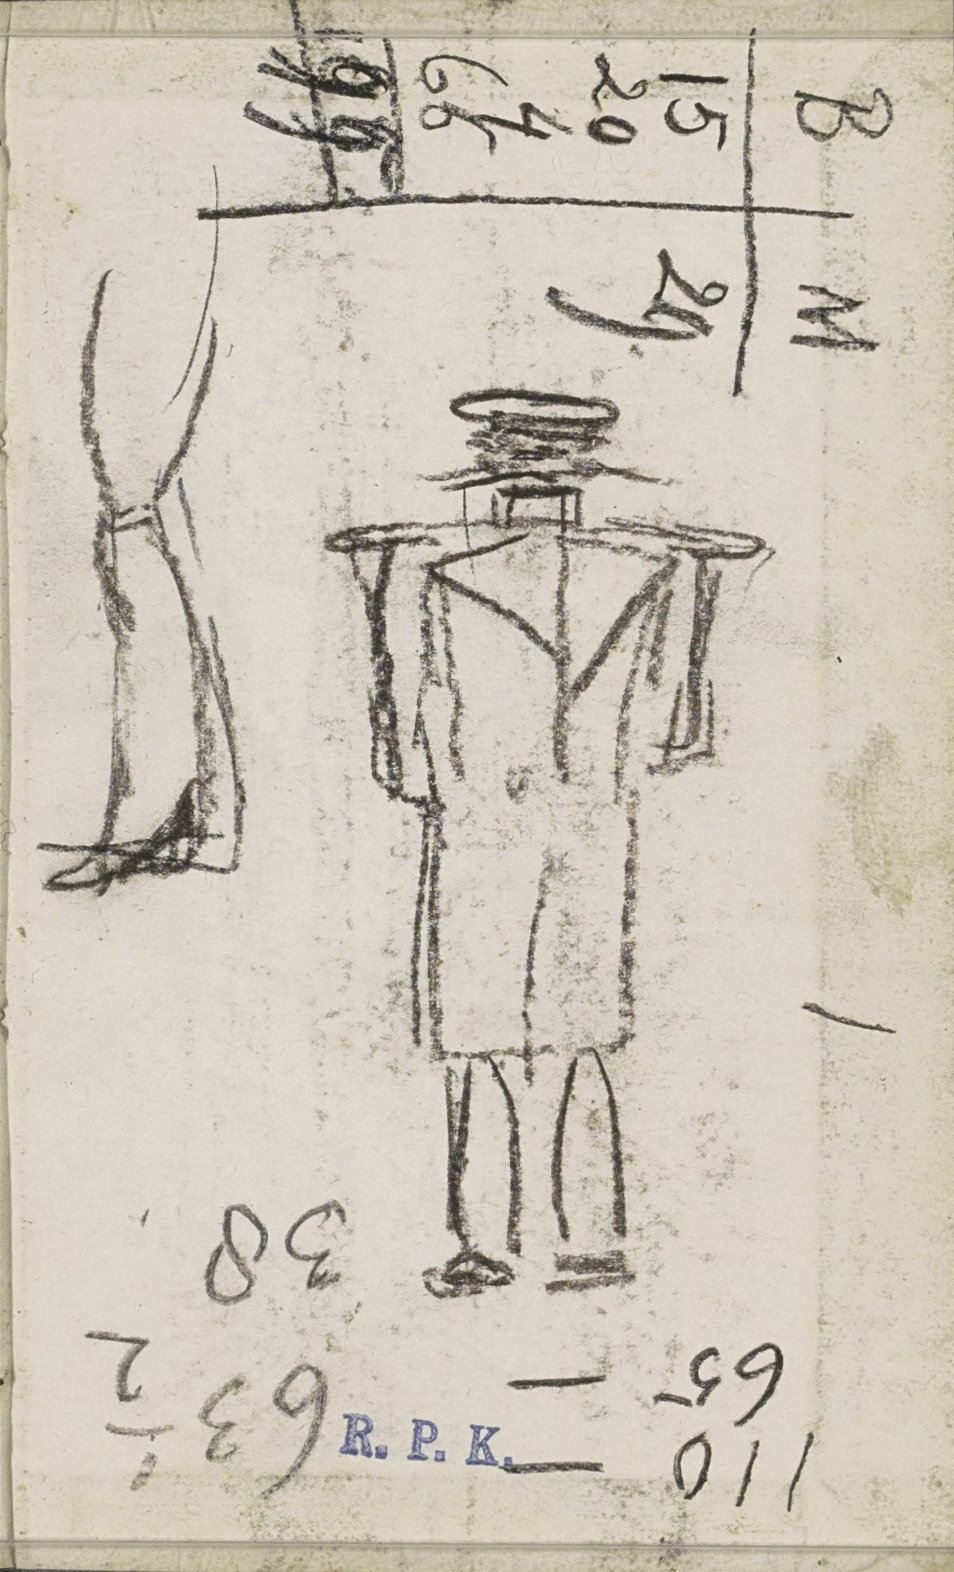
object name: sketchbook leaf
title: Man in een jas tot op de knie, op de rug gezien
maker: anton mauve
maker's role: draughtsman, painter, print maker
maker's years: 1838-1888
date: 1848-1888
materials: chalk, paper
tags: coat, adult man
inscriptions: annotation: ‘[...]’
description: Tevens een studie van benen. Achterste schutblad uit een schetsboek met 53 bladen.